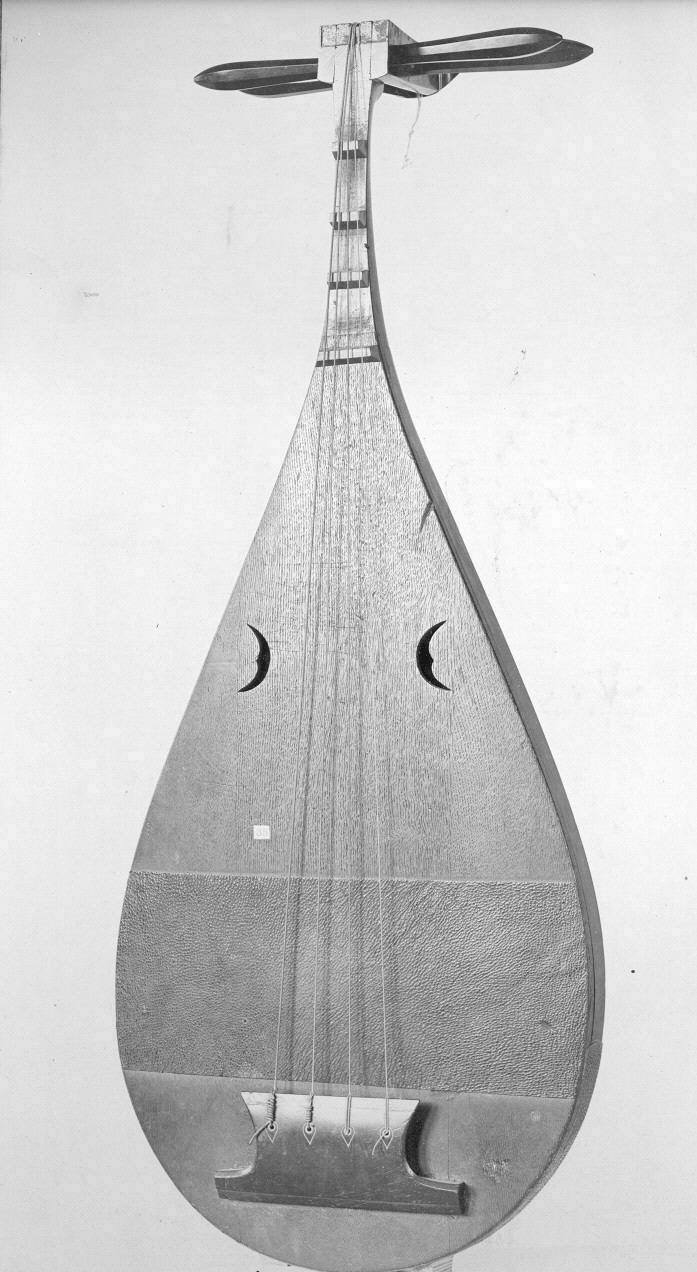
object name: heike biwa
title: Heike Biwa (平家琵琶)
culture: japanese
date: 1835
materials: leather, wood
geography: japan